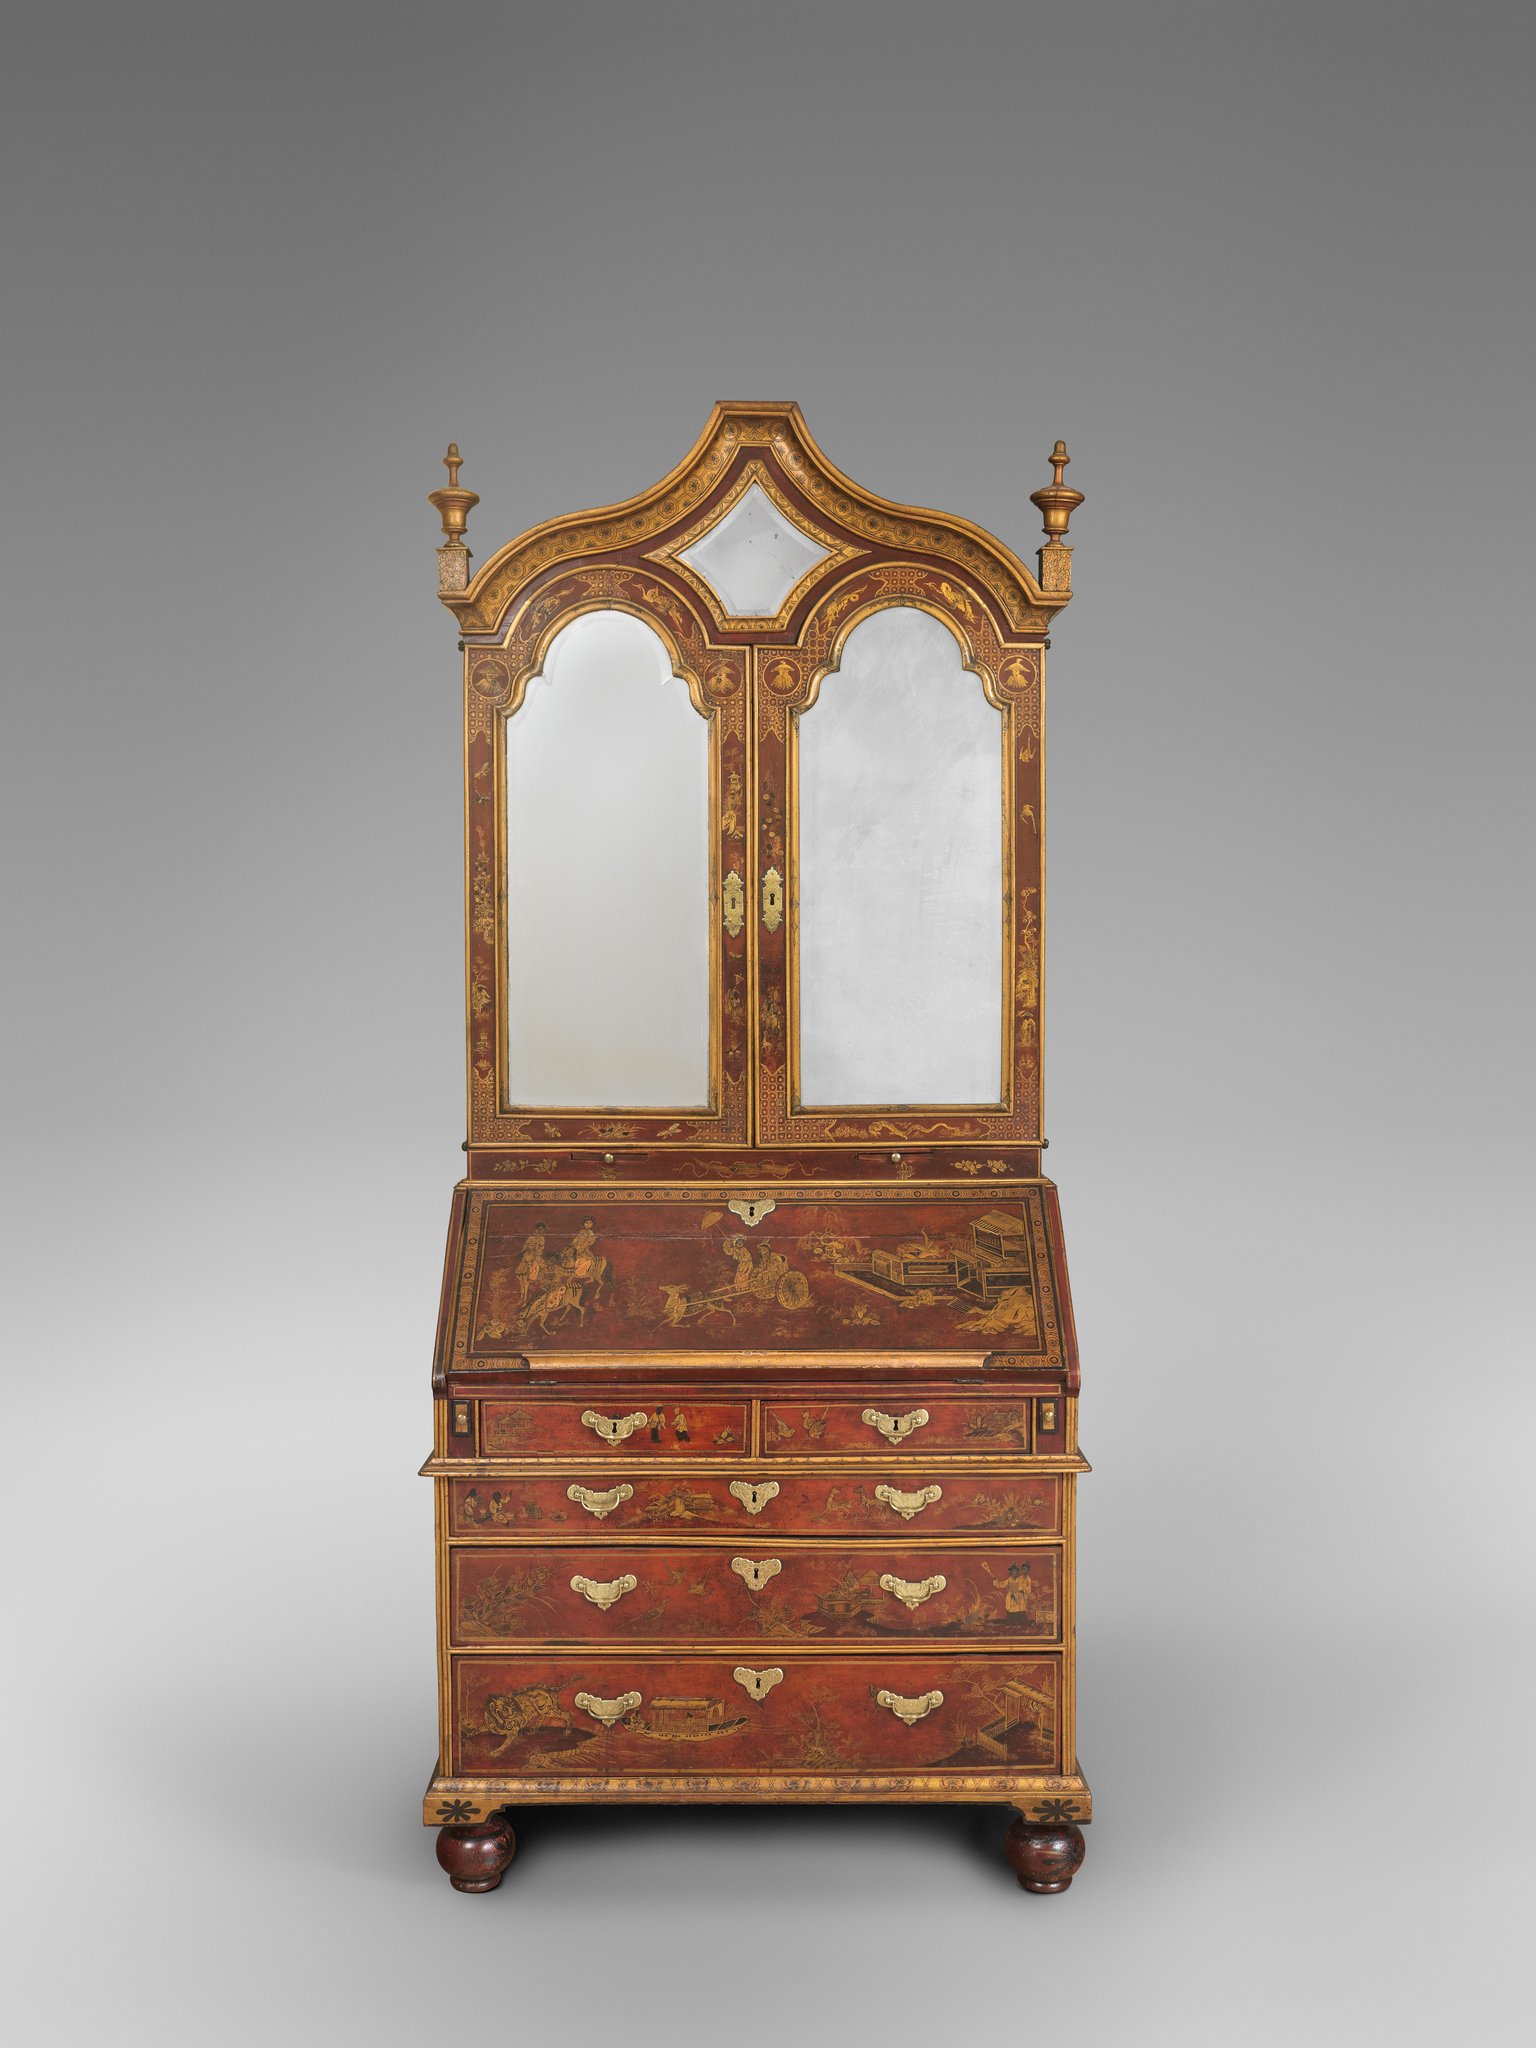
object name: desk and bookcase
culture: british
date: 1700-1720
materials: wood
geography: england